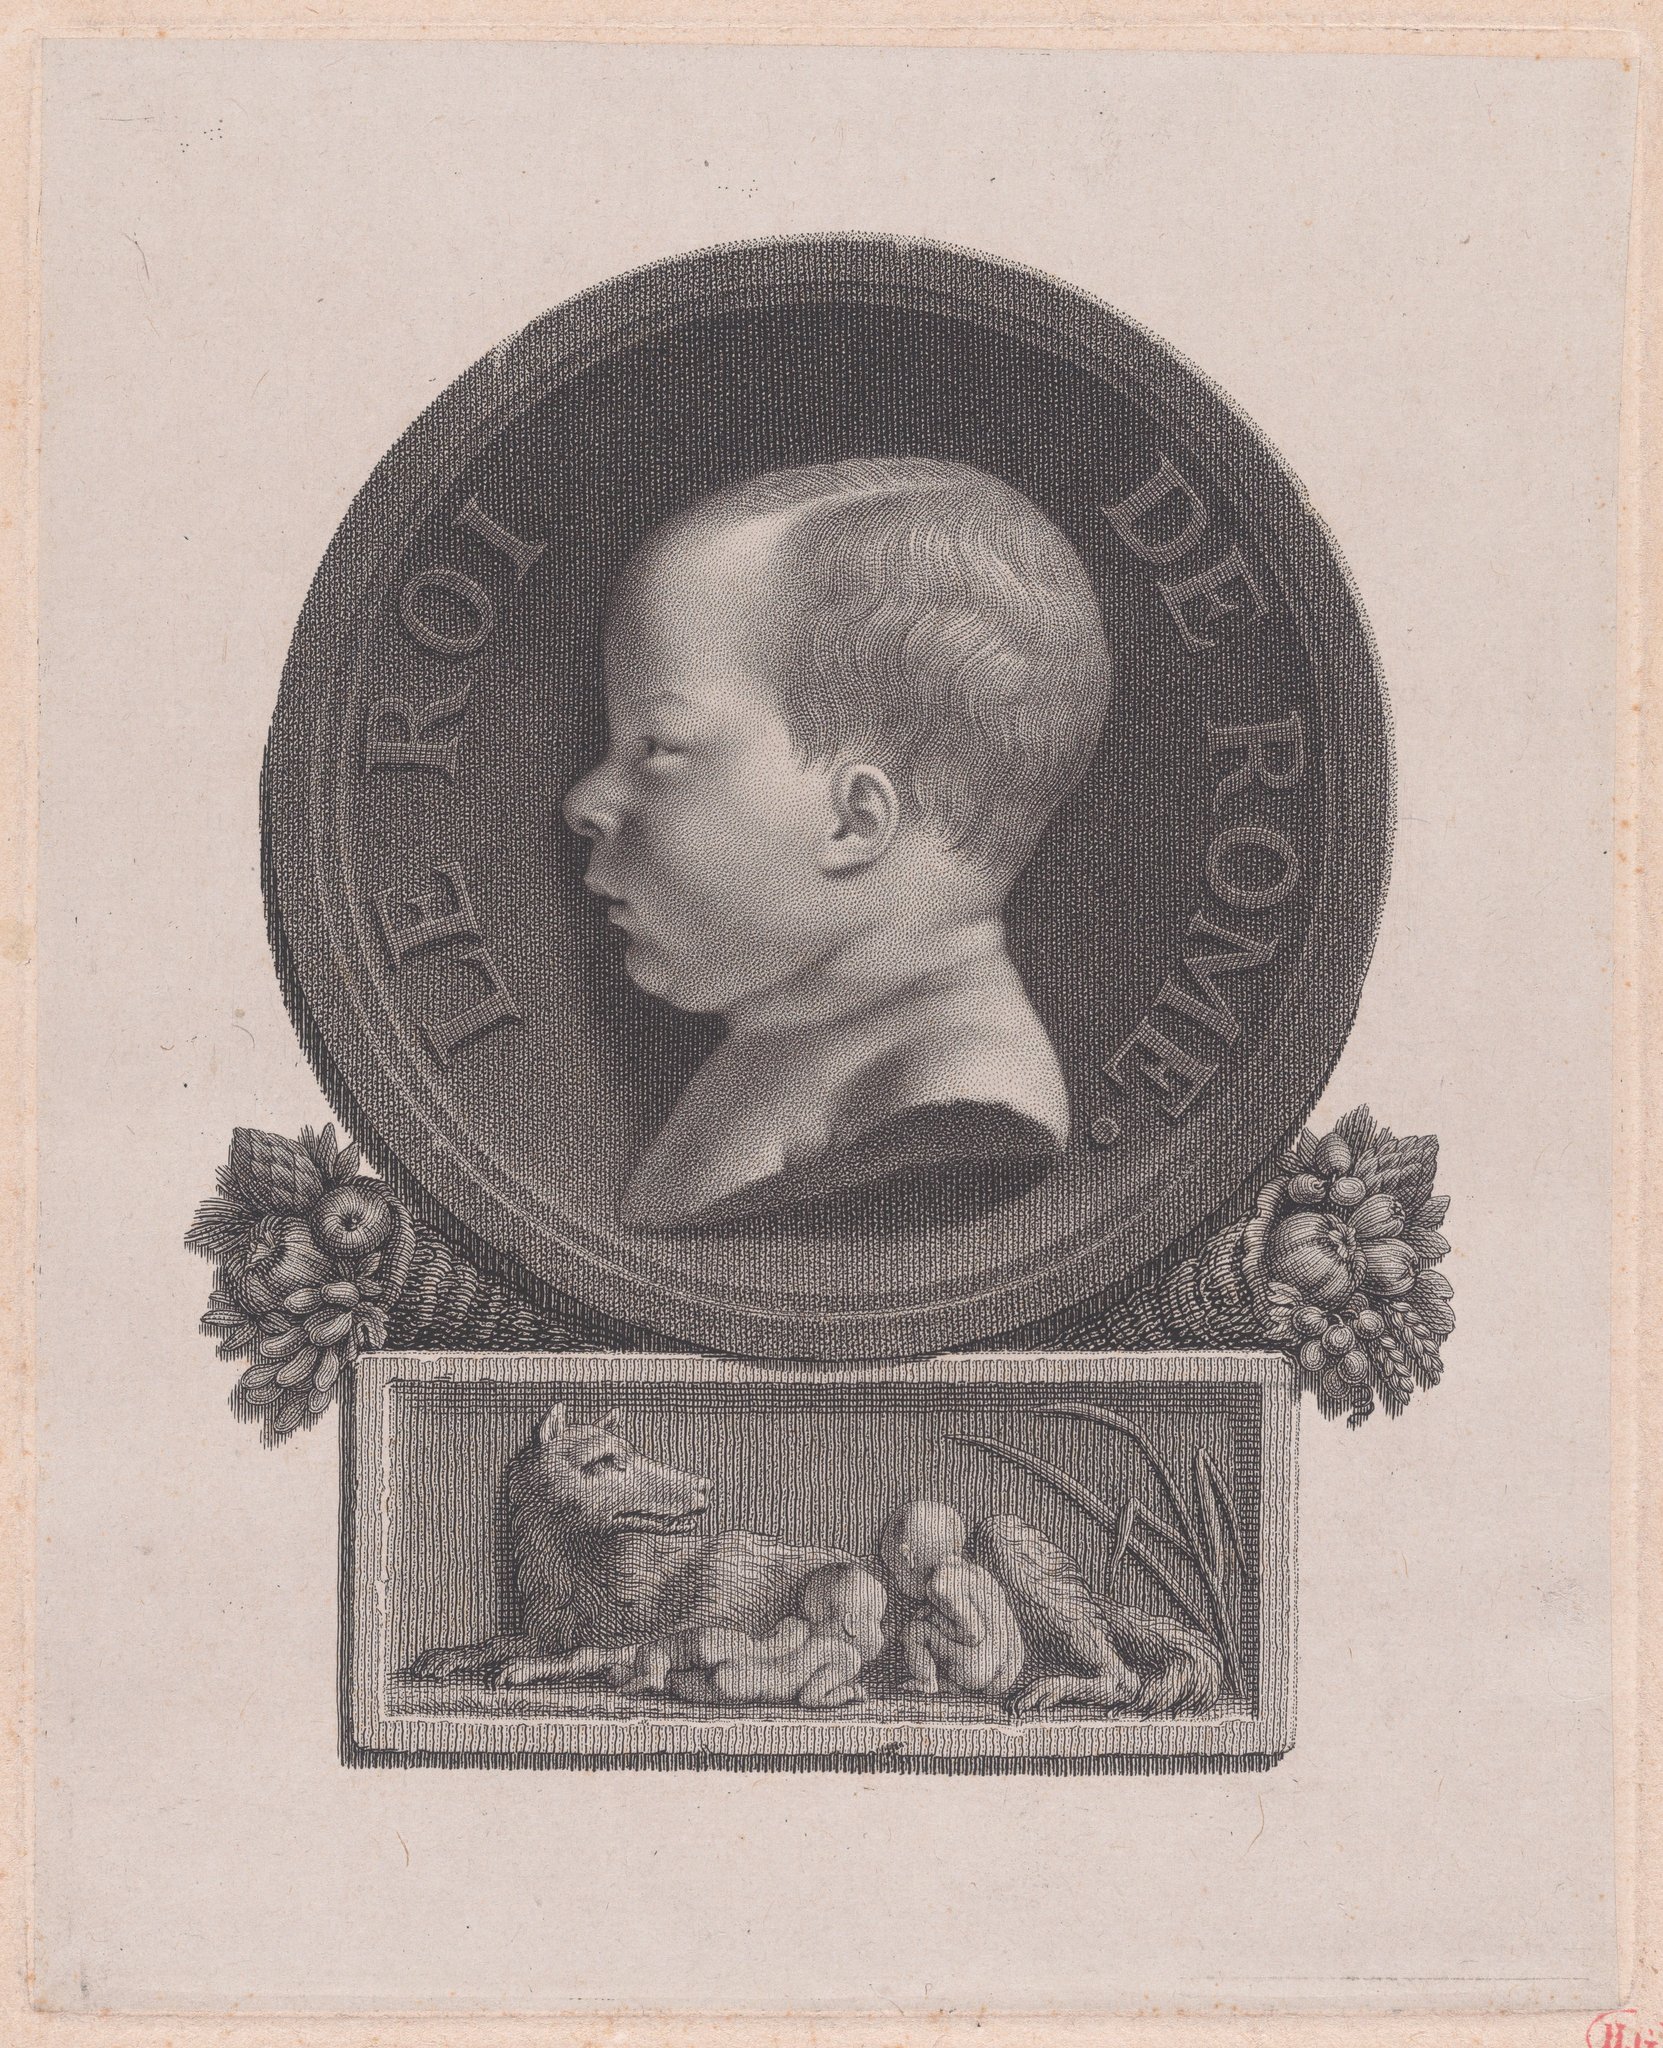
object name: print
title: The King of Rome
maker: pierre paul prud'hon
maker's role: artist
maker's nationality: french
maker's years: 1758-1823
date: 1811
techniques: printmaking, etching, engraving